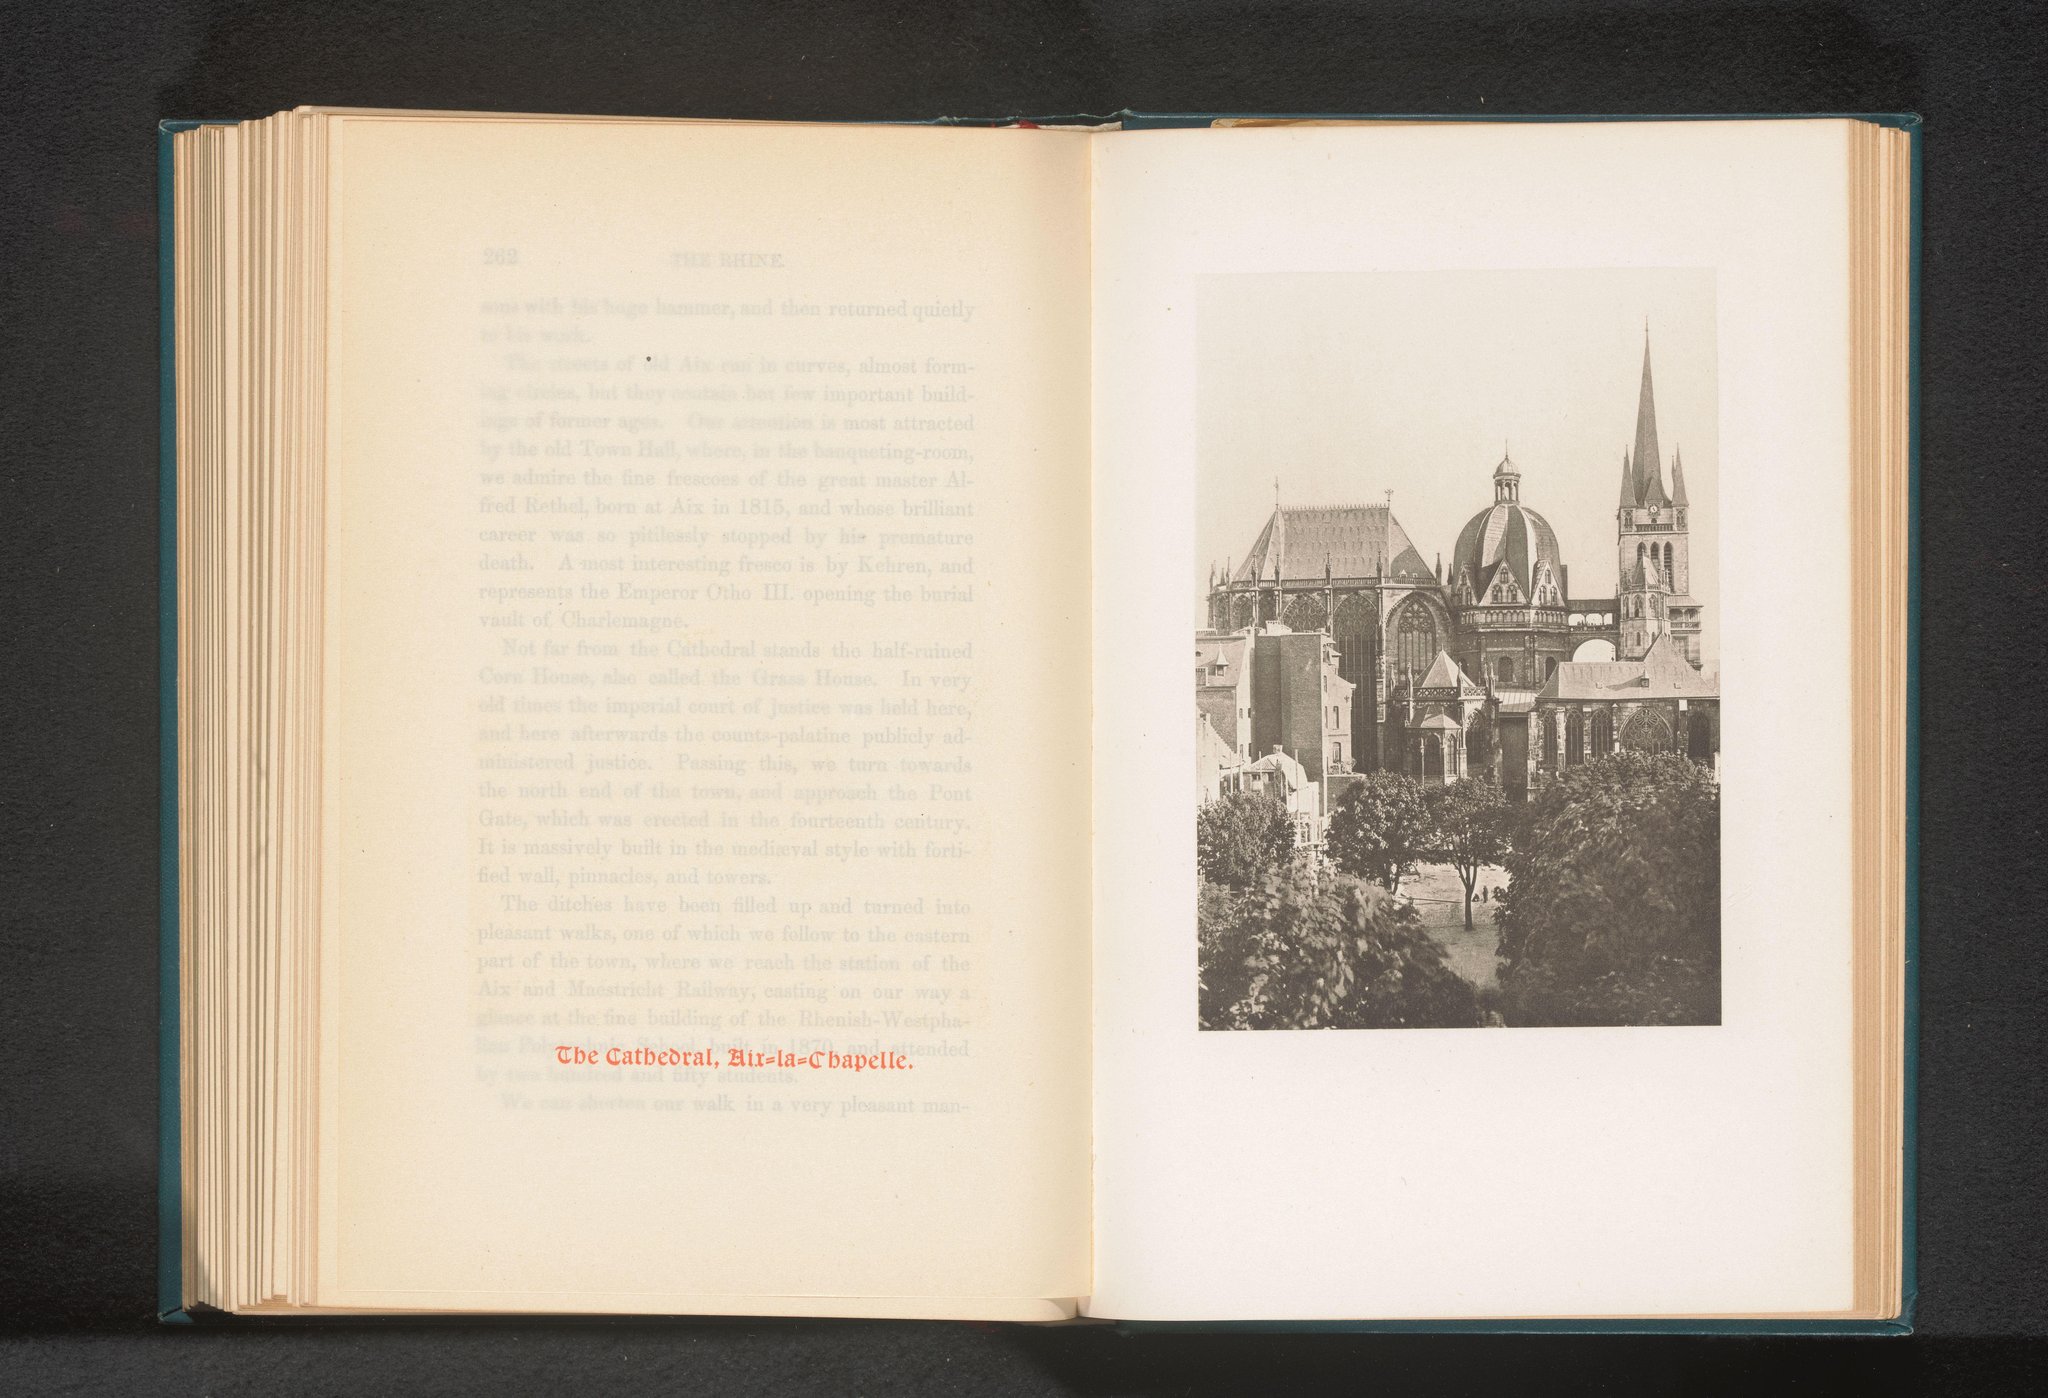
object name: photomechanical print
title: Exterieur van de Dom van Keulen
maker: Anonymous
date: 1889-1899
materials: paper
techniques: photoaquatint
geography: cologne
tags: church (exterior)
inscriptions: title: ‘Cathedral of Cologne.’